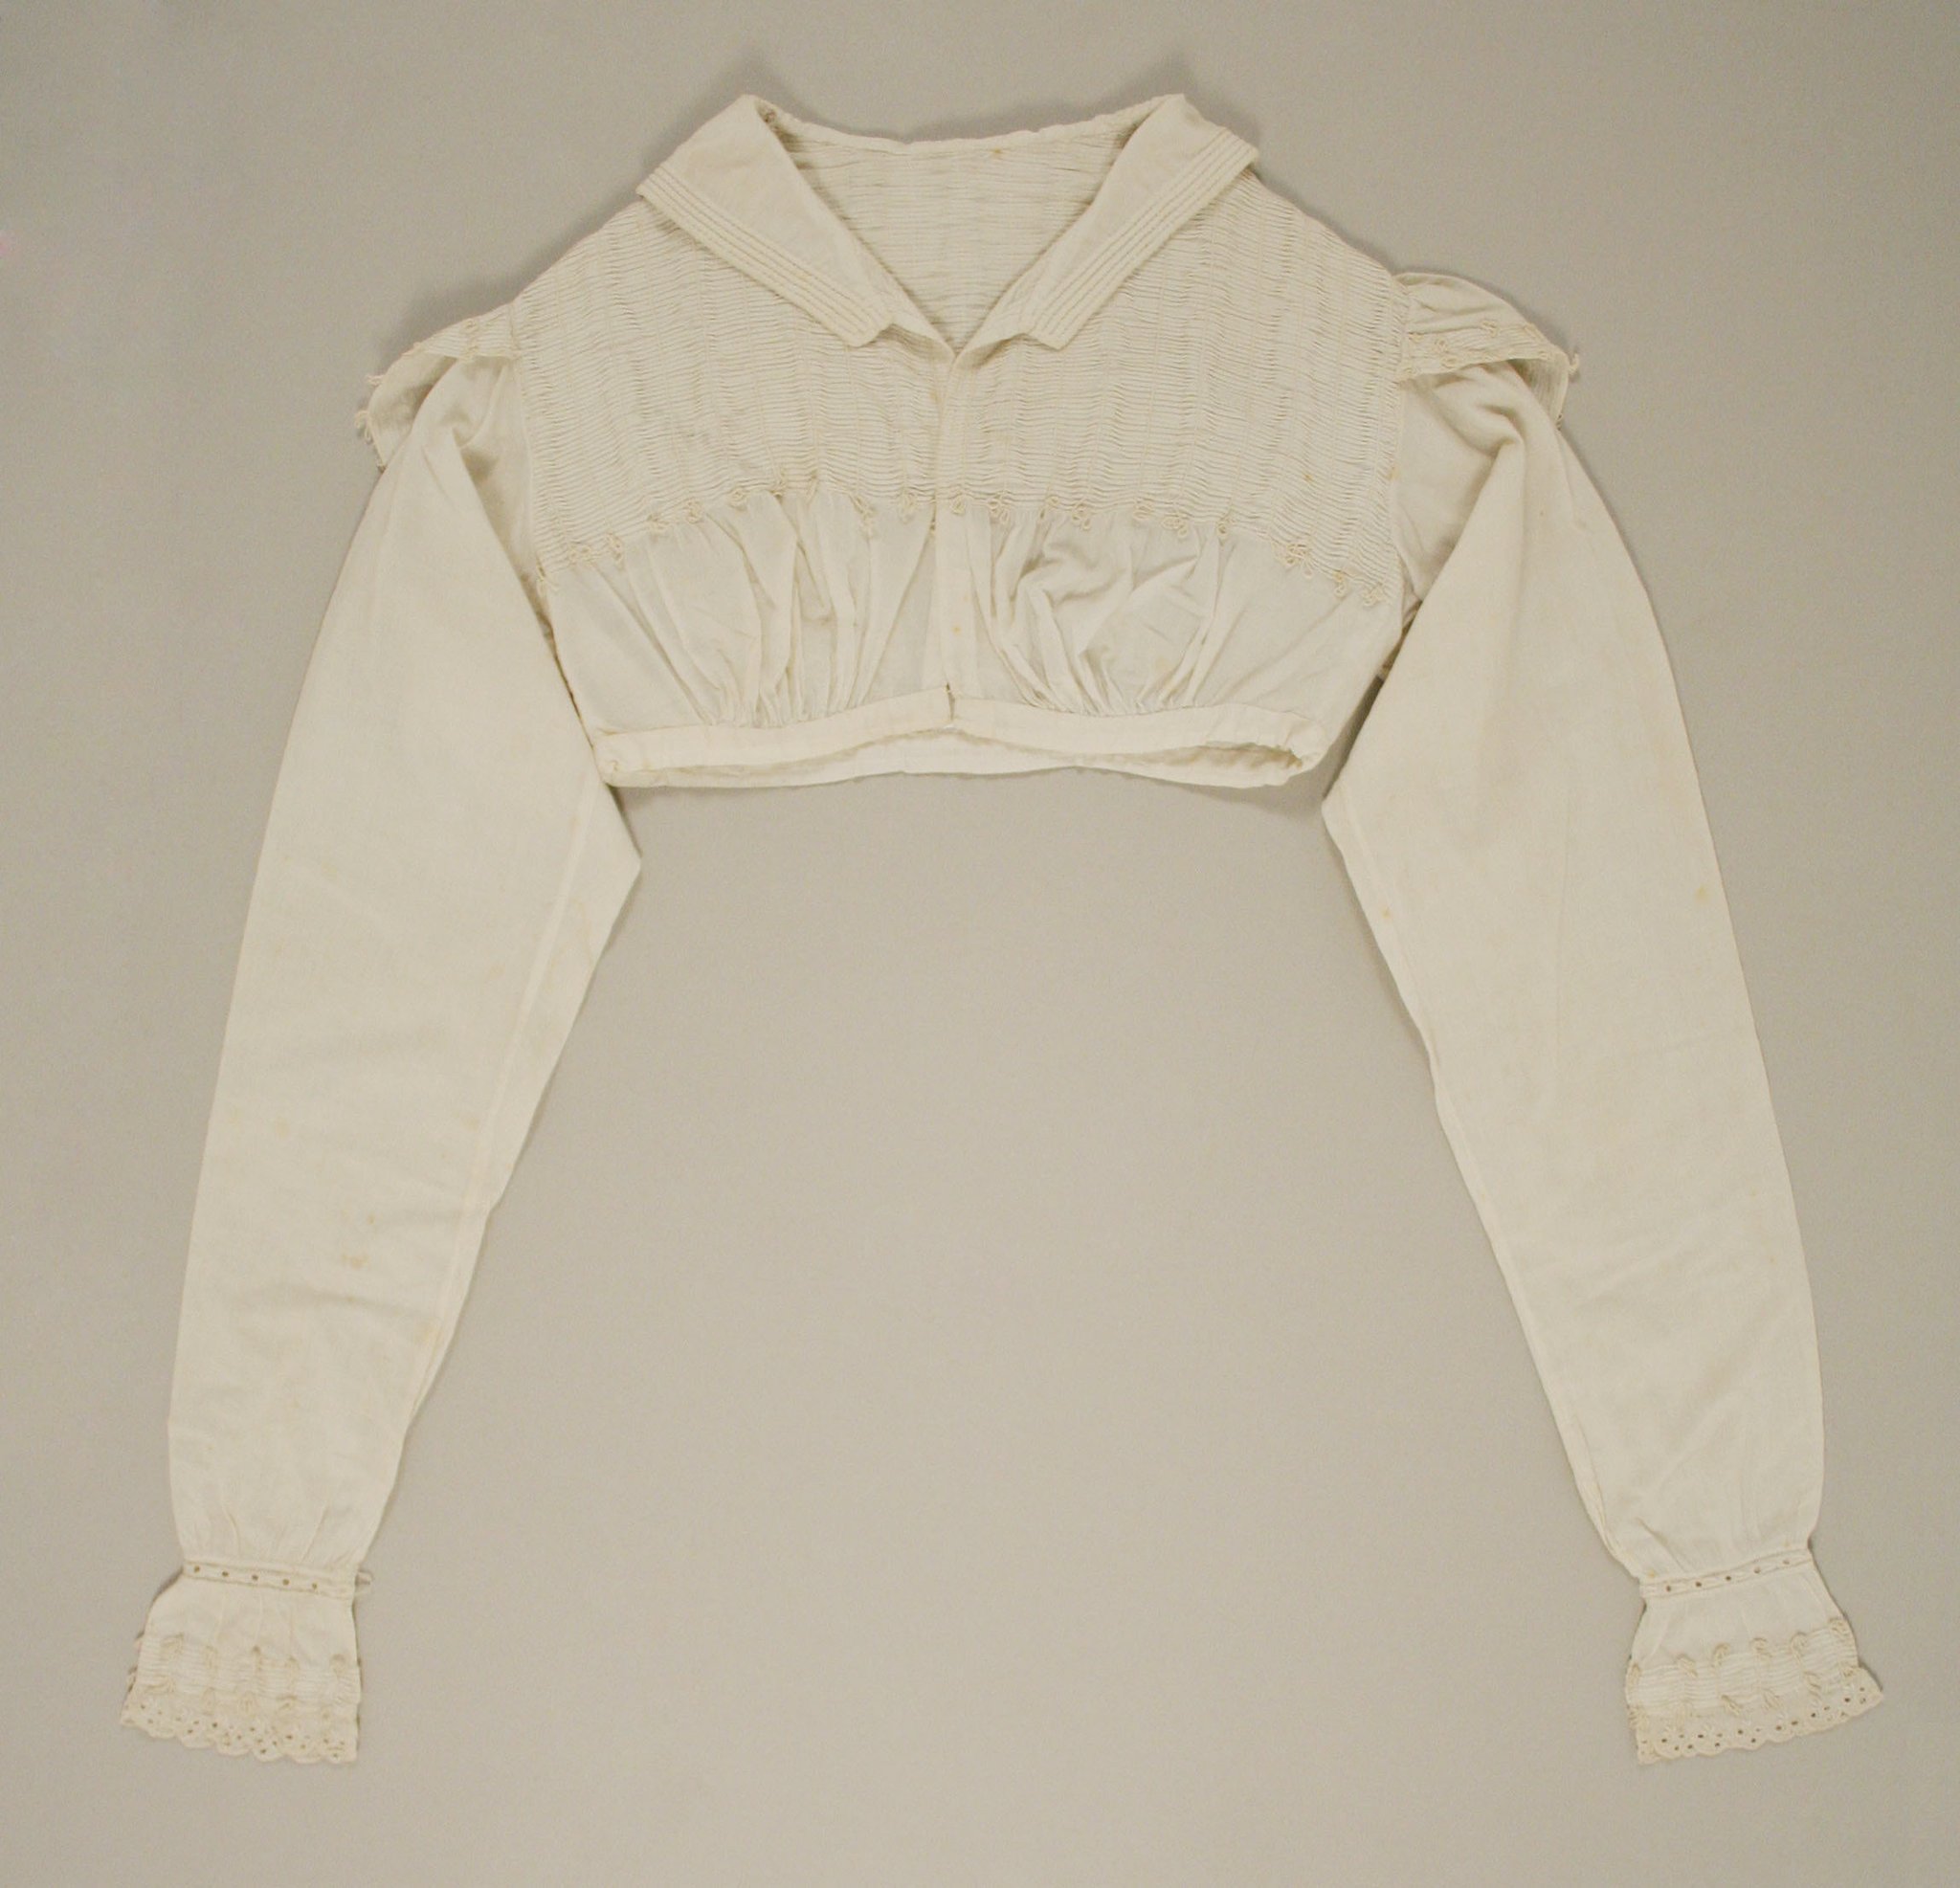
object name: spencer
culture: british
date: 1805-1815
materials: cotton